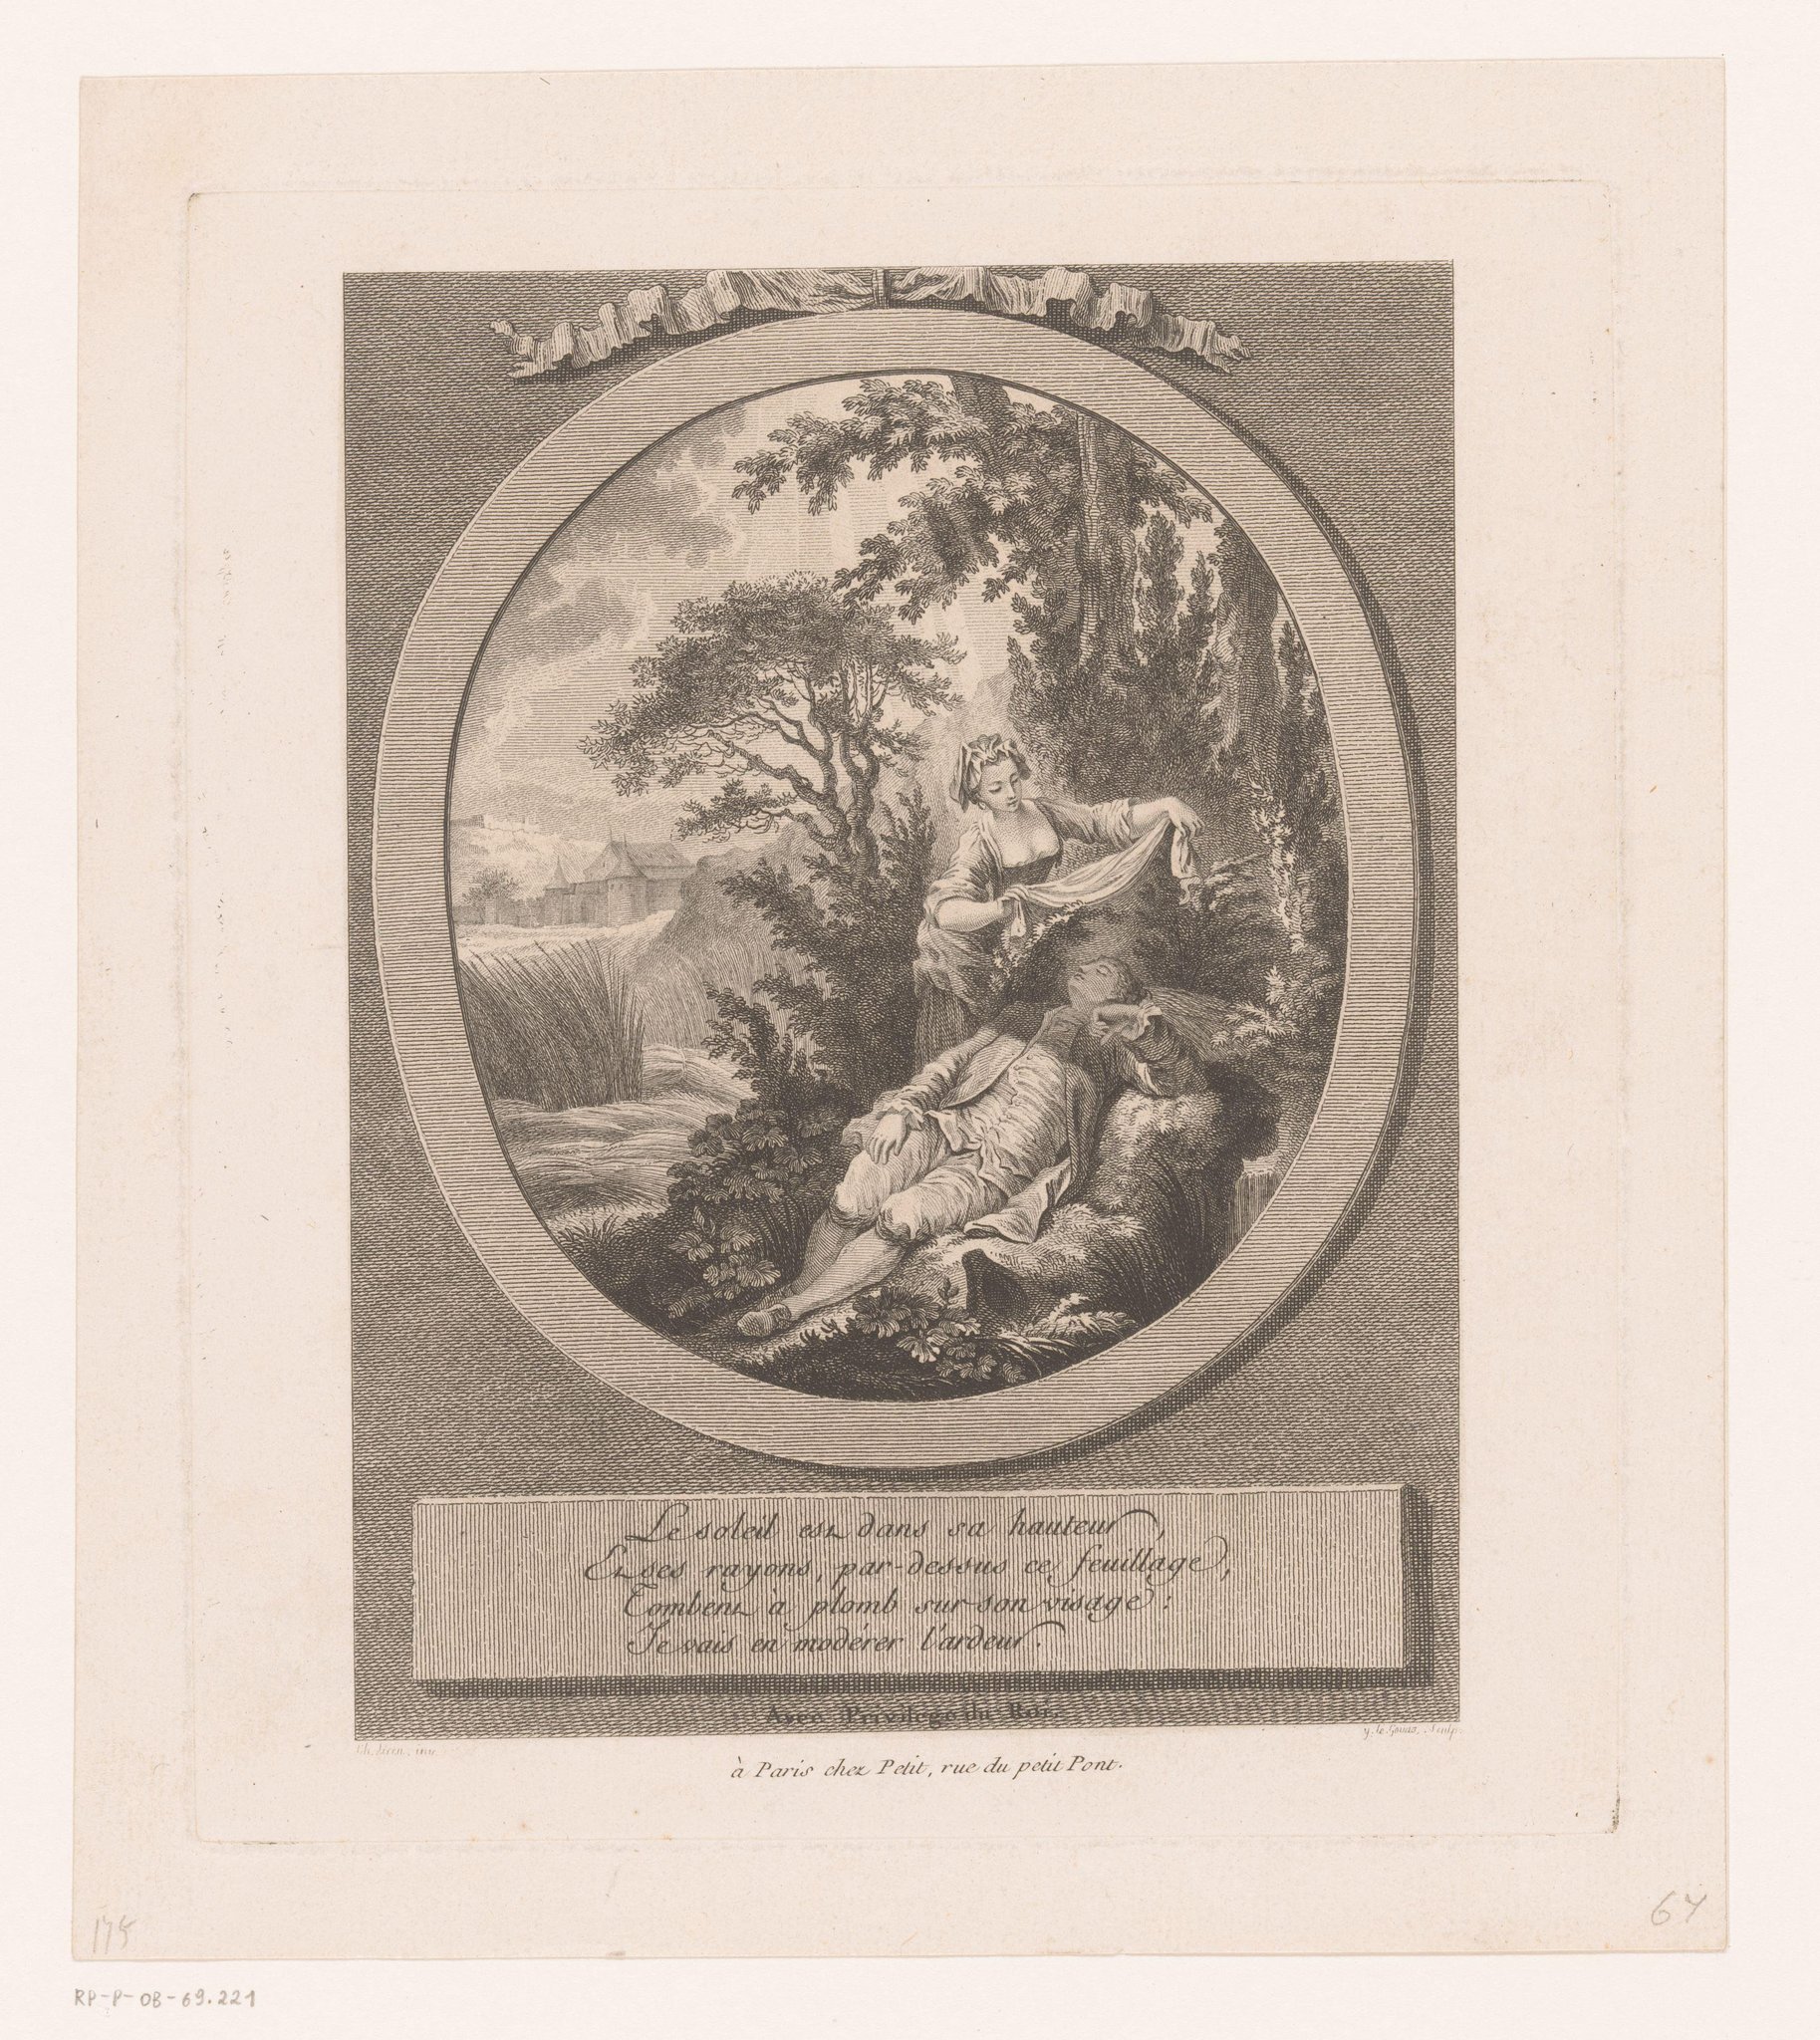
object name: print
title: Toneelscènes uit Les Moissonneurs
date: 1768-1816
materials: paper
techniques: engraving, etching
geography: france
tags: ornament ~ medallion, shadow, sunlight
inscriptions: collector's mark: Lugt 2228